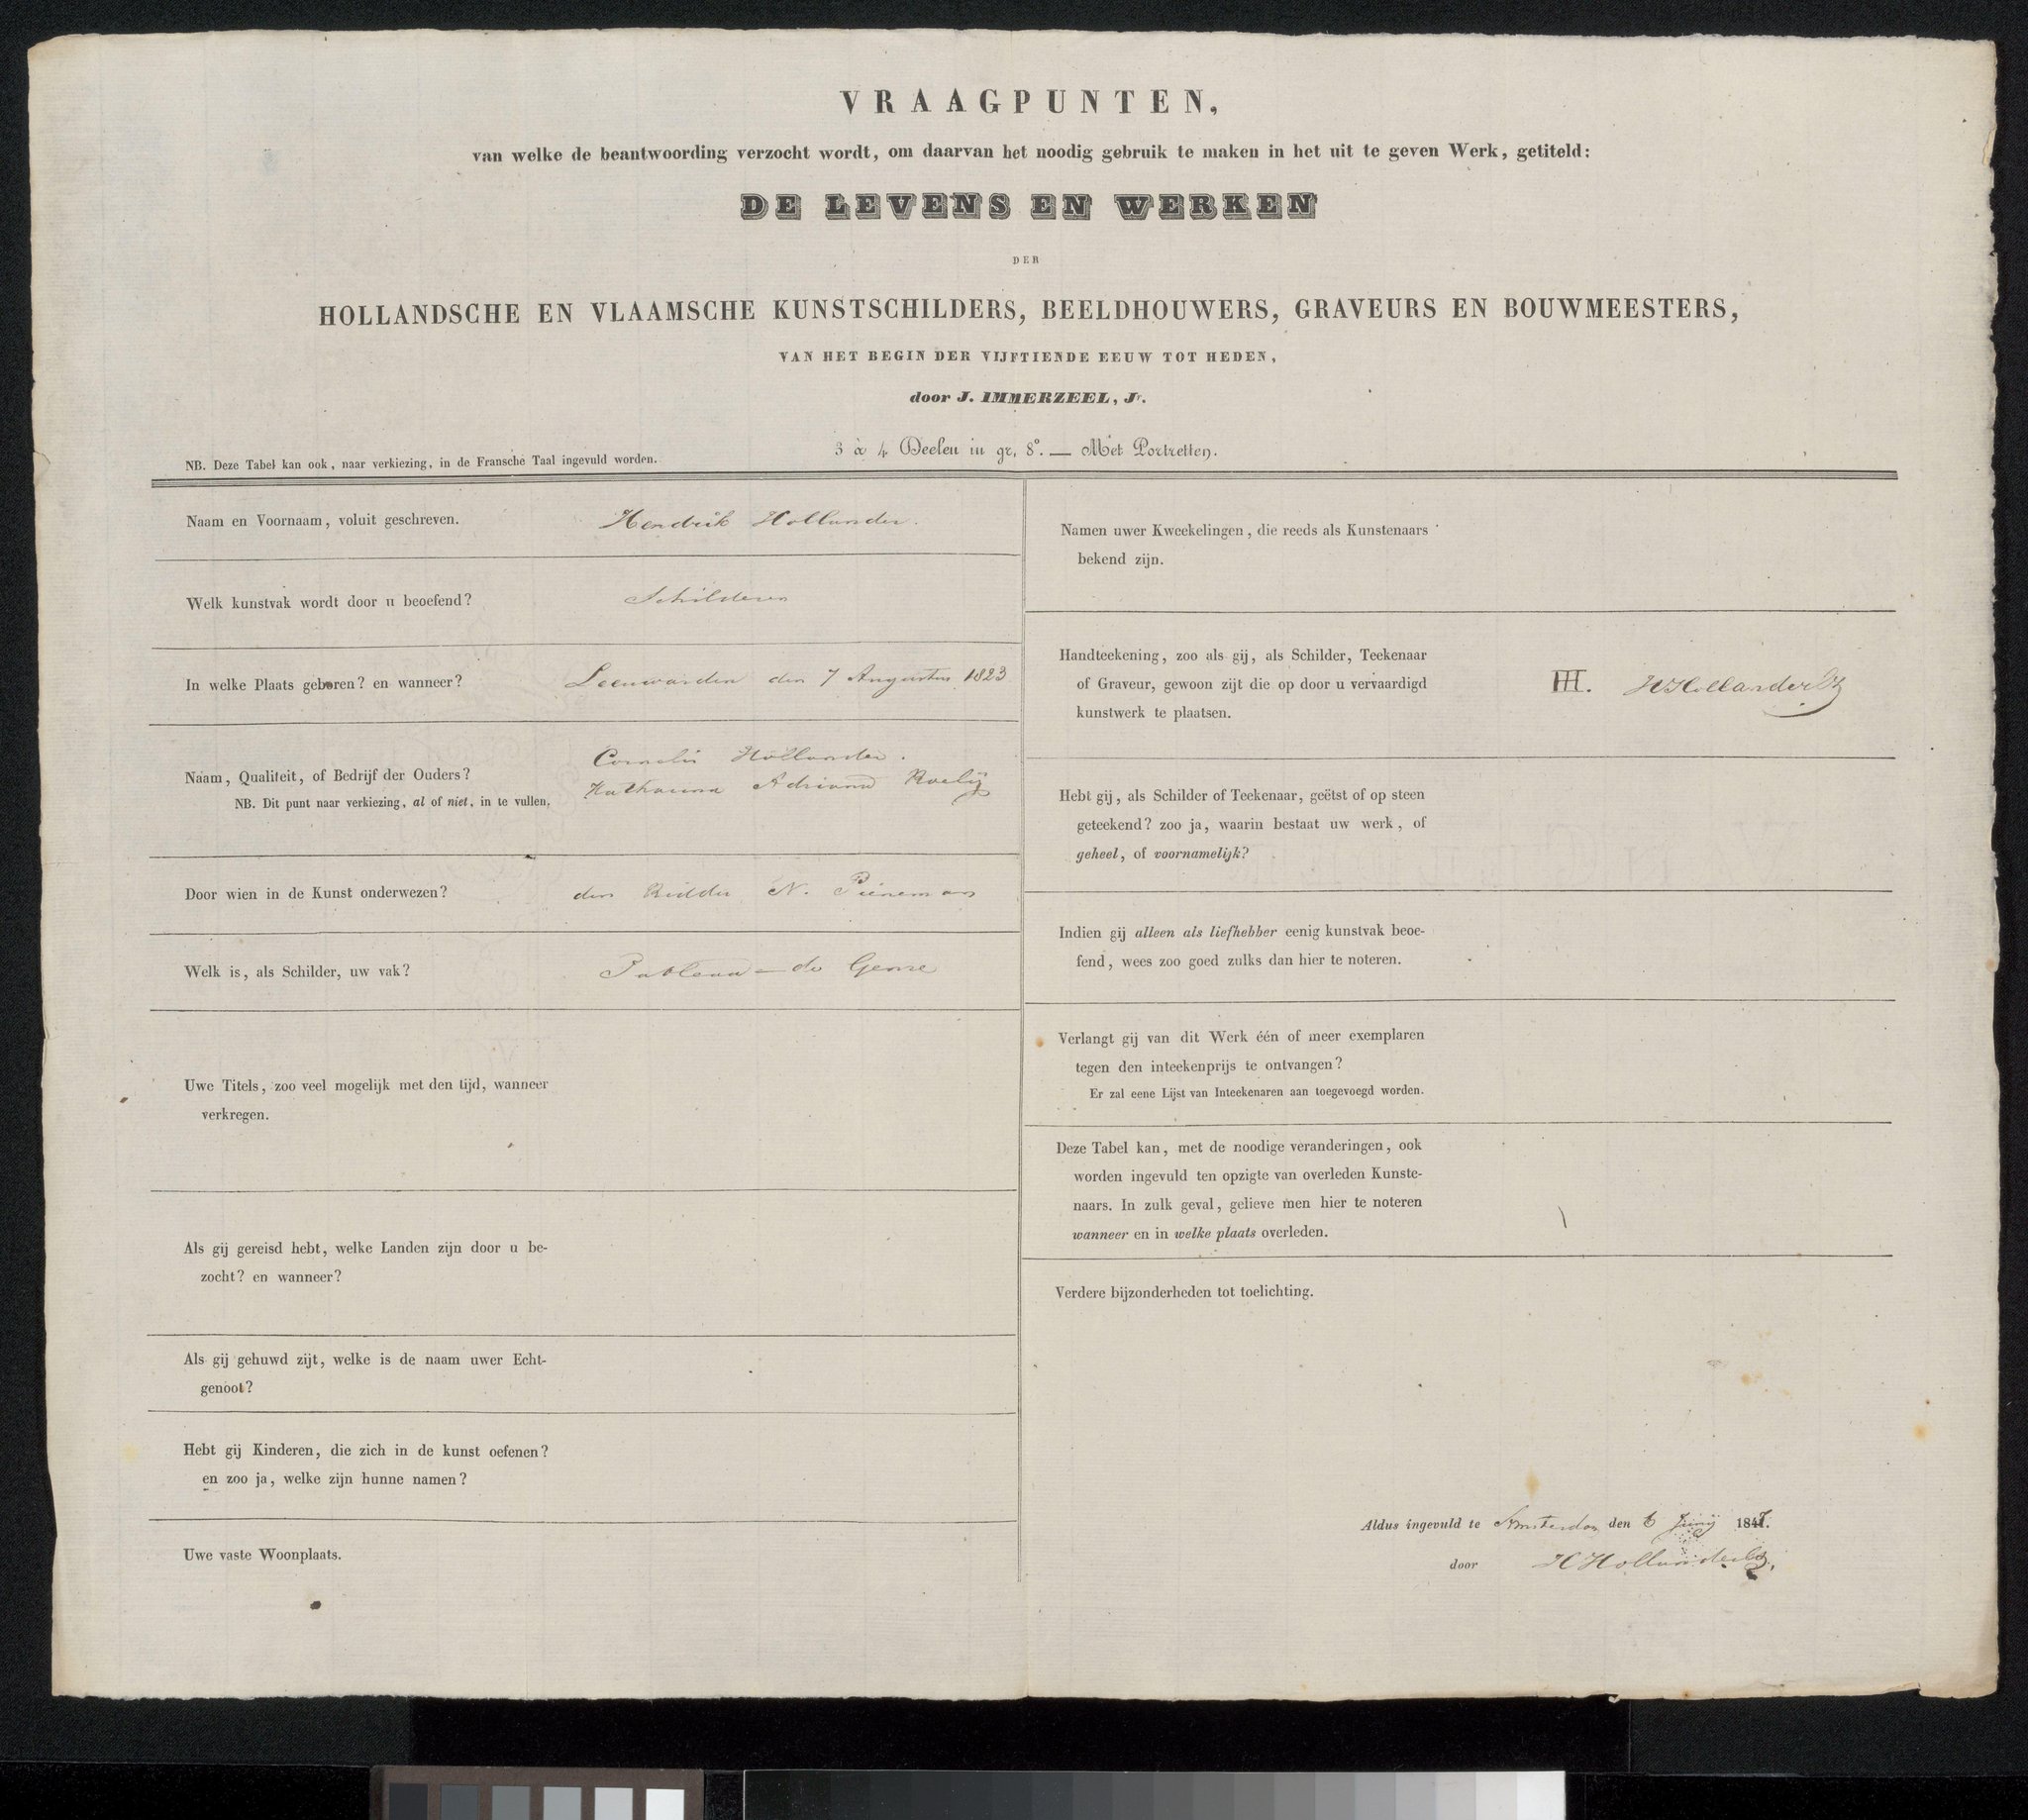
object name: manuscript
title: Enquêteformulier ingevuld door Hendrik Hollander Cz.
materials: ink, paper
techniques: pen, printing, writing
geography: amsterdam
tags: amsterdam, painter, print maker, hendrik hollander cz.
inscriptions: inscription: ‘Vraagpunten,/ van welke de beantwoording verzocht wordt, om daarvan het noodig gebruik te maken in het uit te geven Werk, getiteld: De levens en werken/ der Hollandsche en Vlaamsche kunstschilders, beeldhouwers,/ graveurs en bouwmeesters, van het begin der vijftiende eeuw tot heden/ door J. Immerzeel, Jr.’, watermark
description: Opgenomen in: Immerzeel, J. Jr., De levens en werken der Hollandsche en Vlaamsche kunstschilders, beeldhouwers, graveurs en bouwmeesters, van het begin der vijftiende eeuw tot heden, Amsterdam: J.C. van Kesteren, 1842-1843.